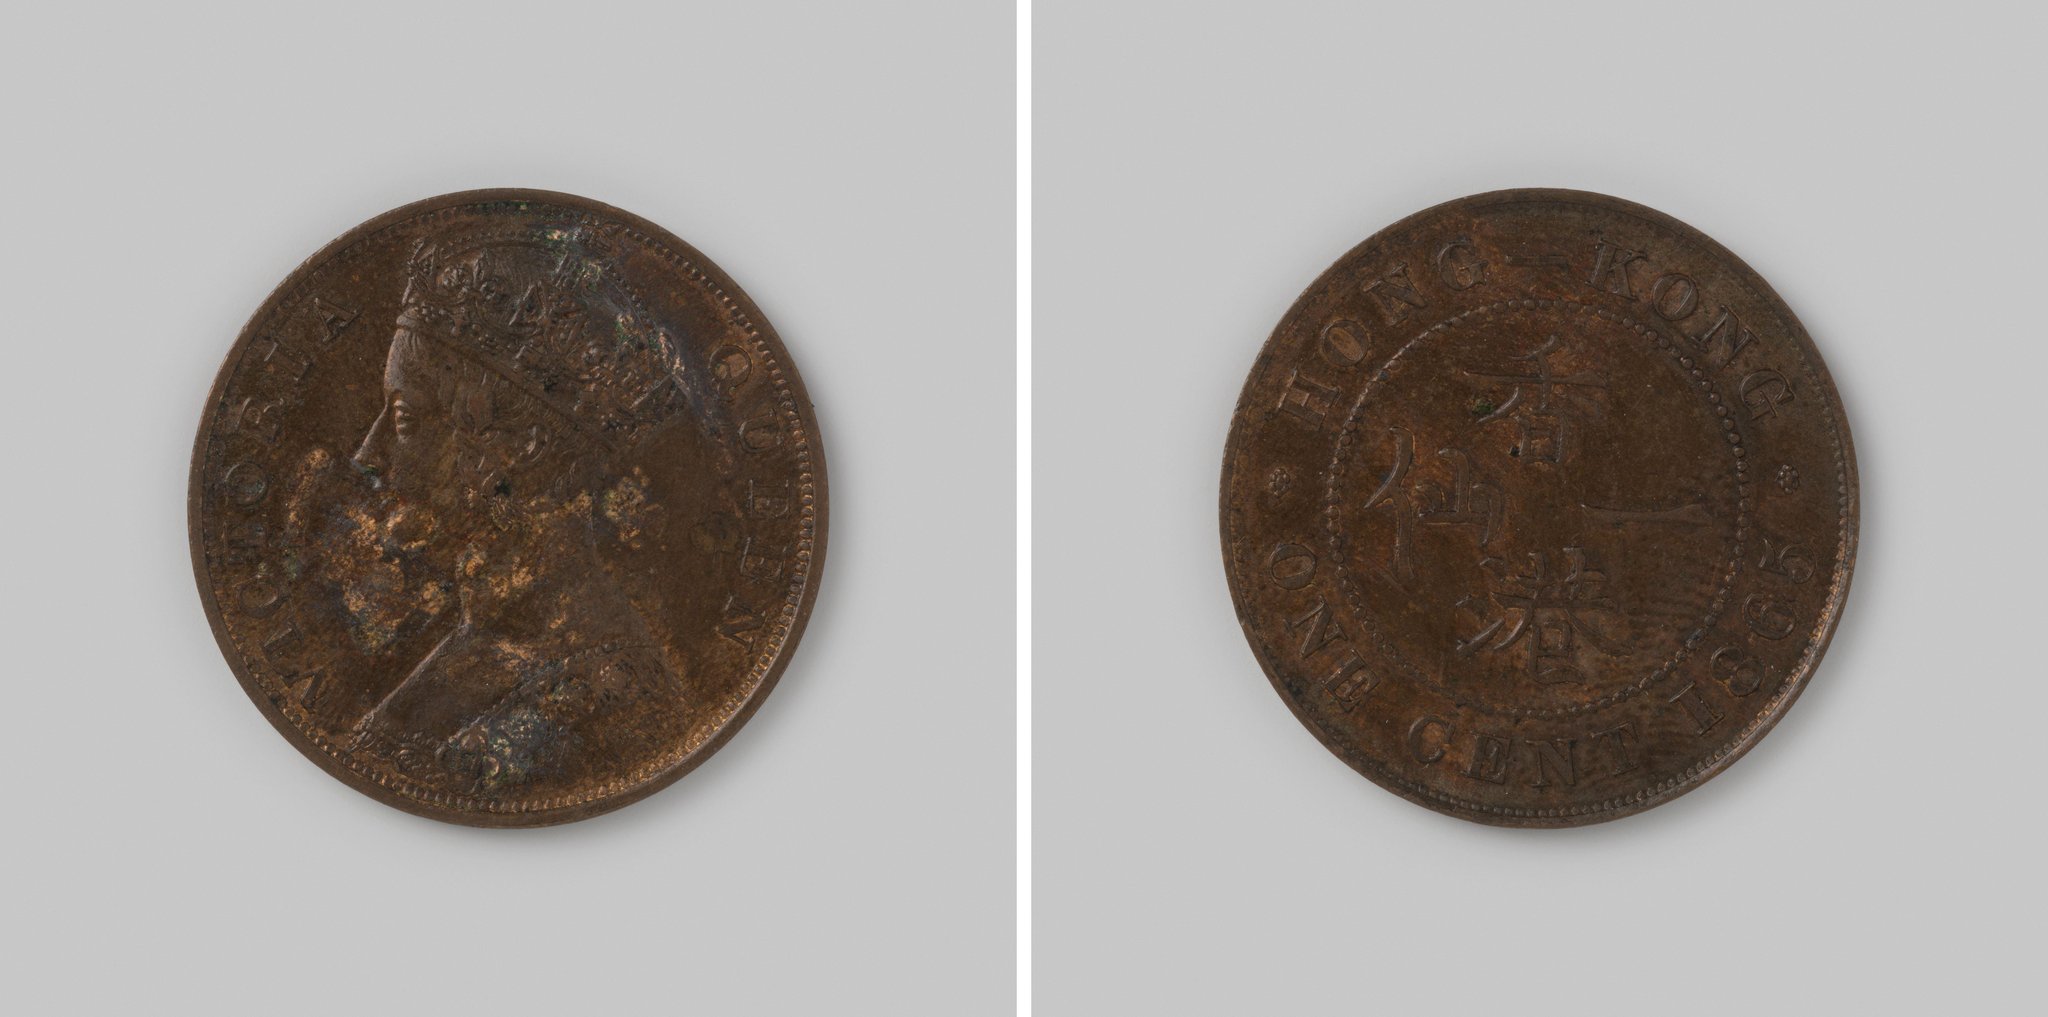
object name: coin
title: Hongkong, koningin Victoria,cent, 1865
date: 1865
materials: bronze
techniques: striking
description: Bronzen munt. Voorzijde: gekroond borstbeeld van de koningin naar links. Keerzijde: in het omschrift waarde-aanduiding: one cent met rechts daarvan jaartal. Gladde rand.